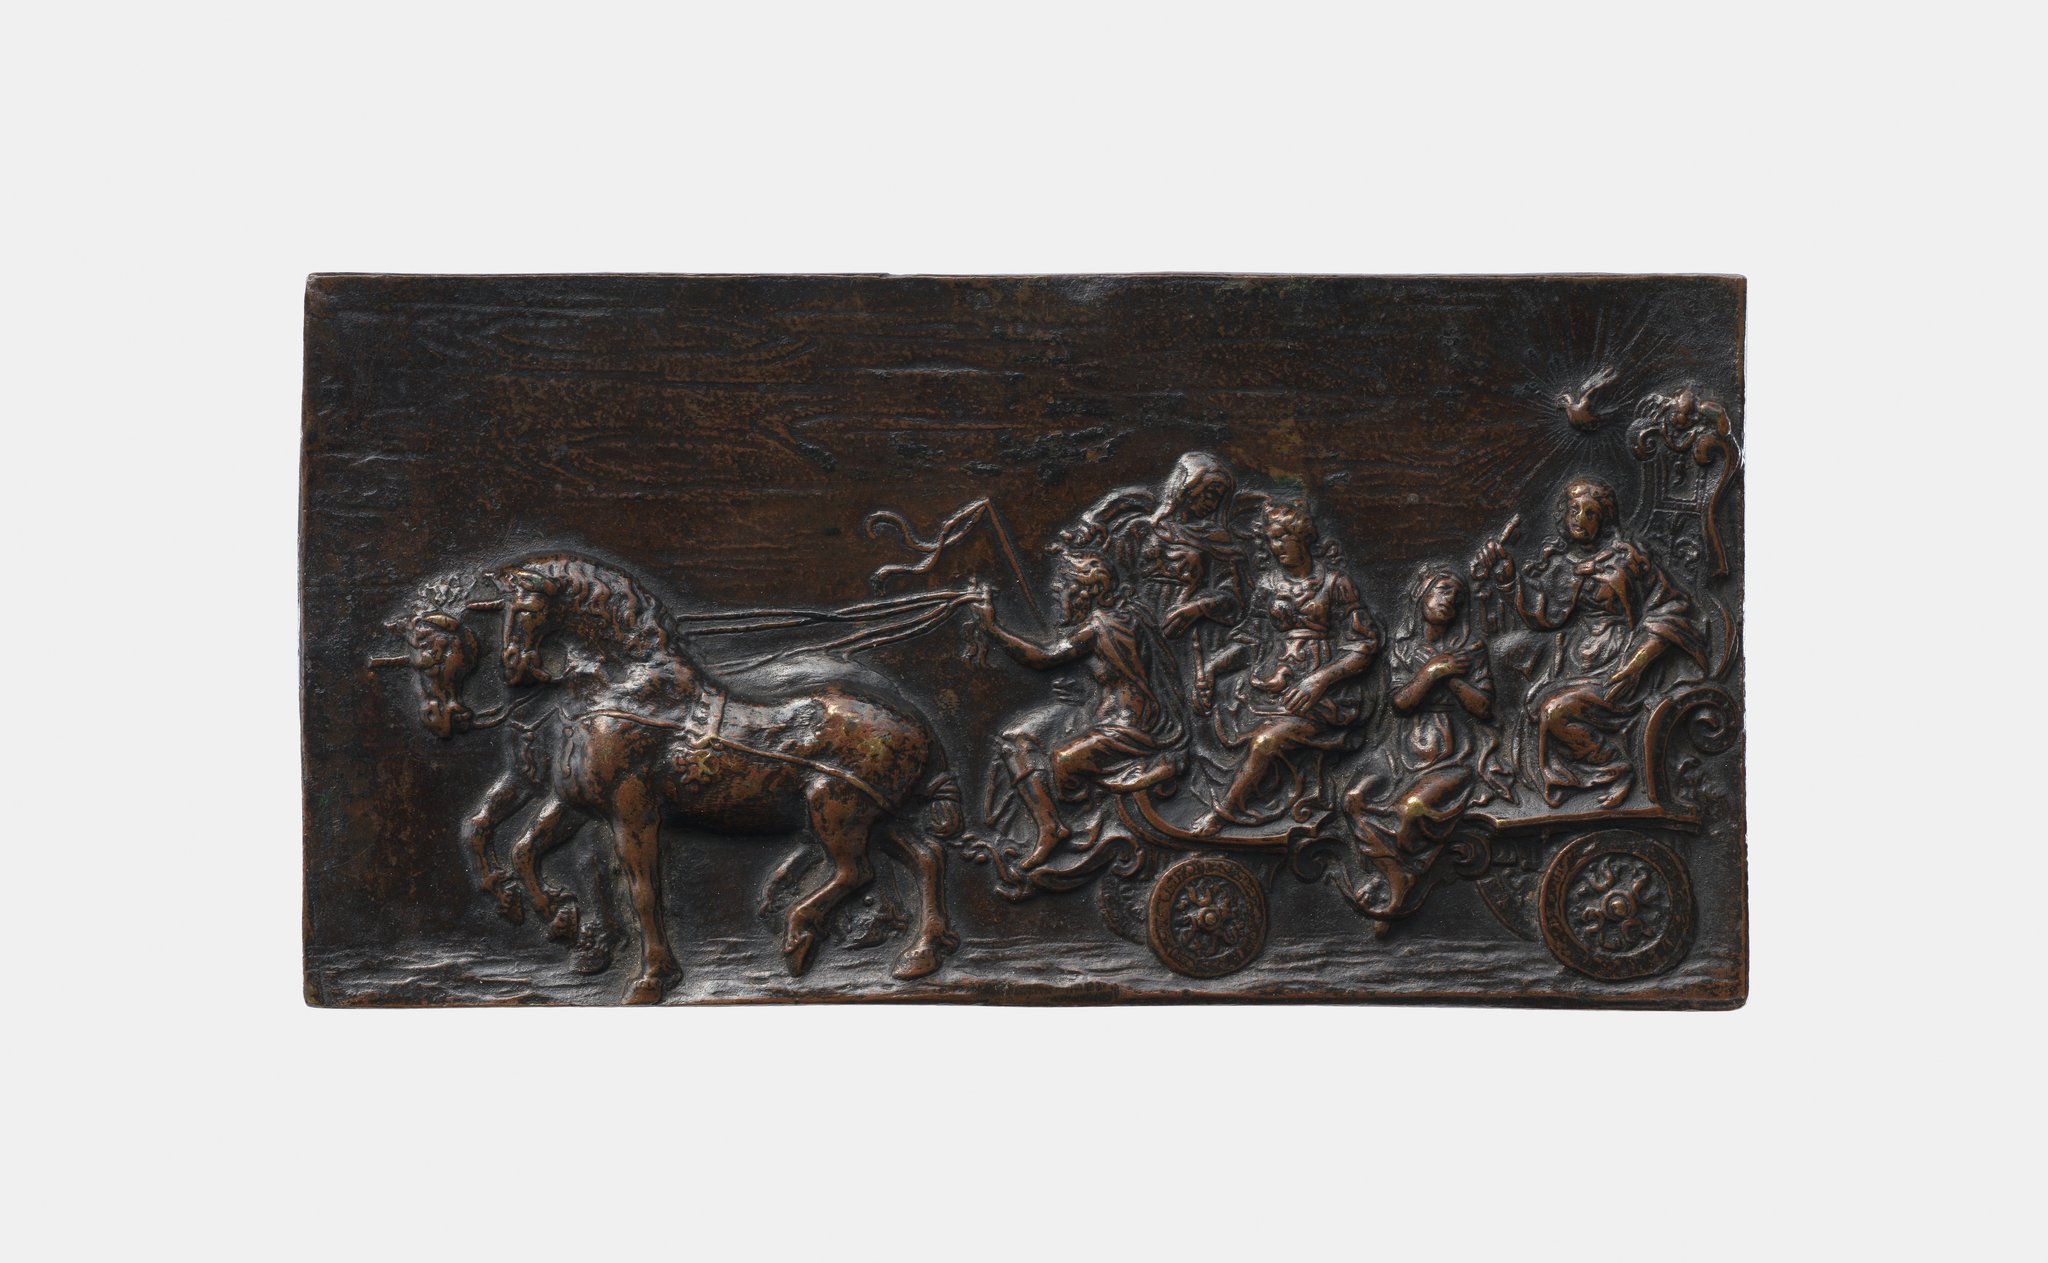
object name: plaquette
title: The Triumph of the Church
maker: Anonymous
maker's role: artist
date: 1500-1599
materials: bronze